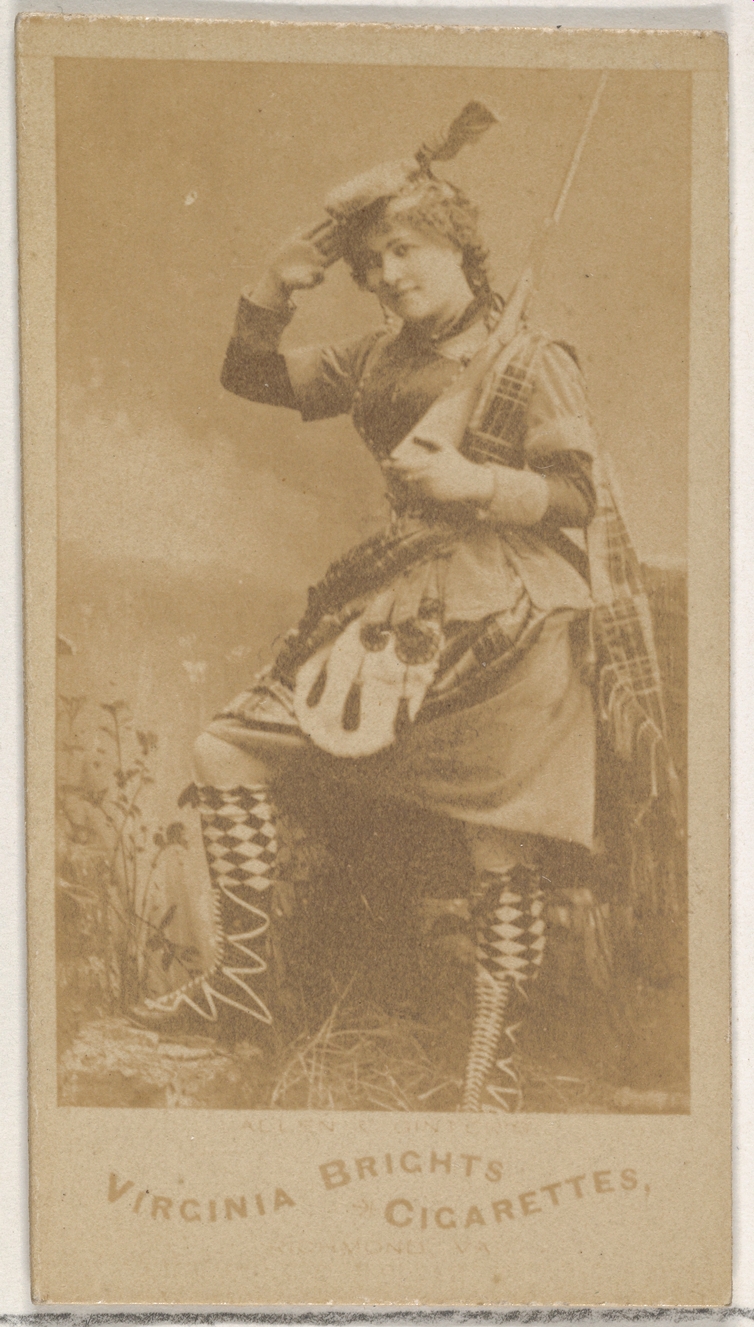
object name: photograph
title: From the Actors and Actresses series (N45, Type 5) for Virginia Brights Cigarettes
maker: allen & ginter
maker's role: publisher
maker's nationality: american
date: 1888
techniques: albumen silver print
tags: portraits,women,actresses